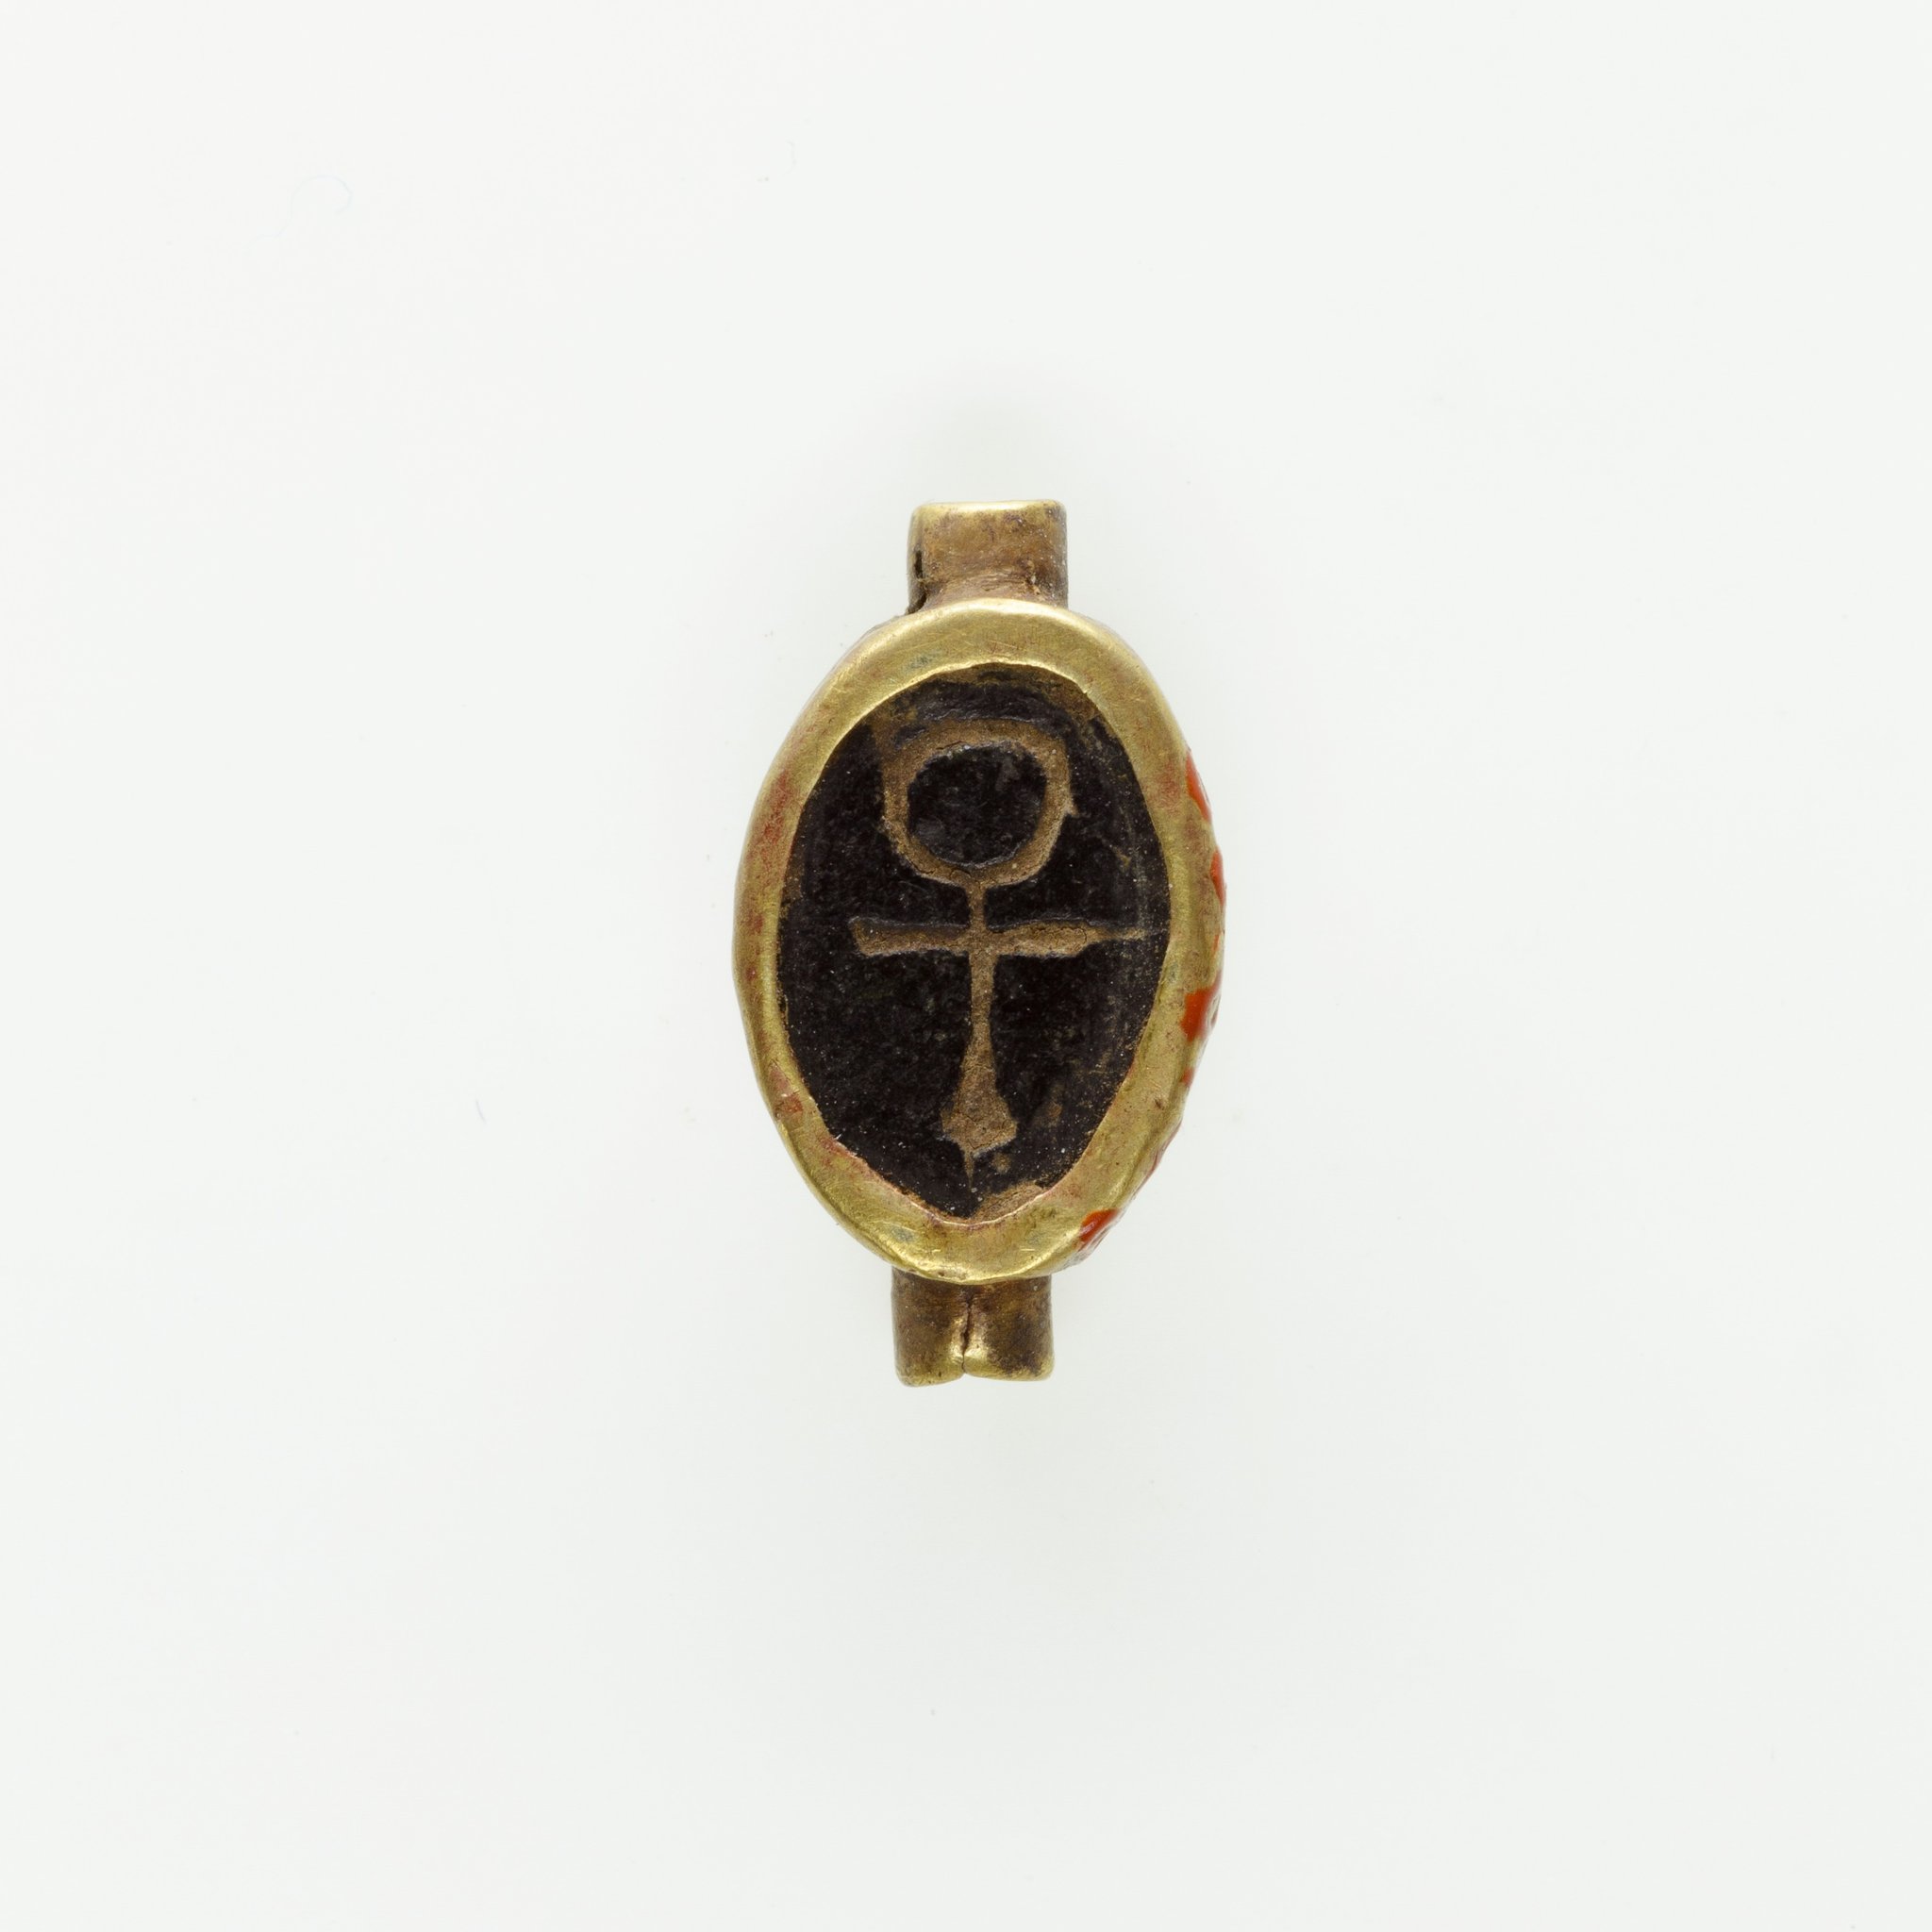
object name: cowroid, ring bezel, ankh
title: Cowroid Inscribed with an Ankh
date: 1492-1473 BCE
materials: gold, mineral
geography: egypt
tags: hieroglyphs,ankh